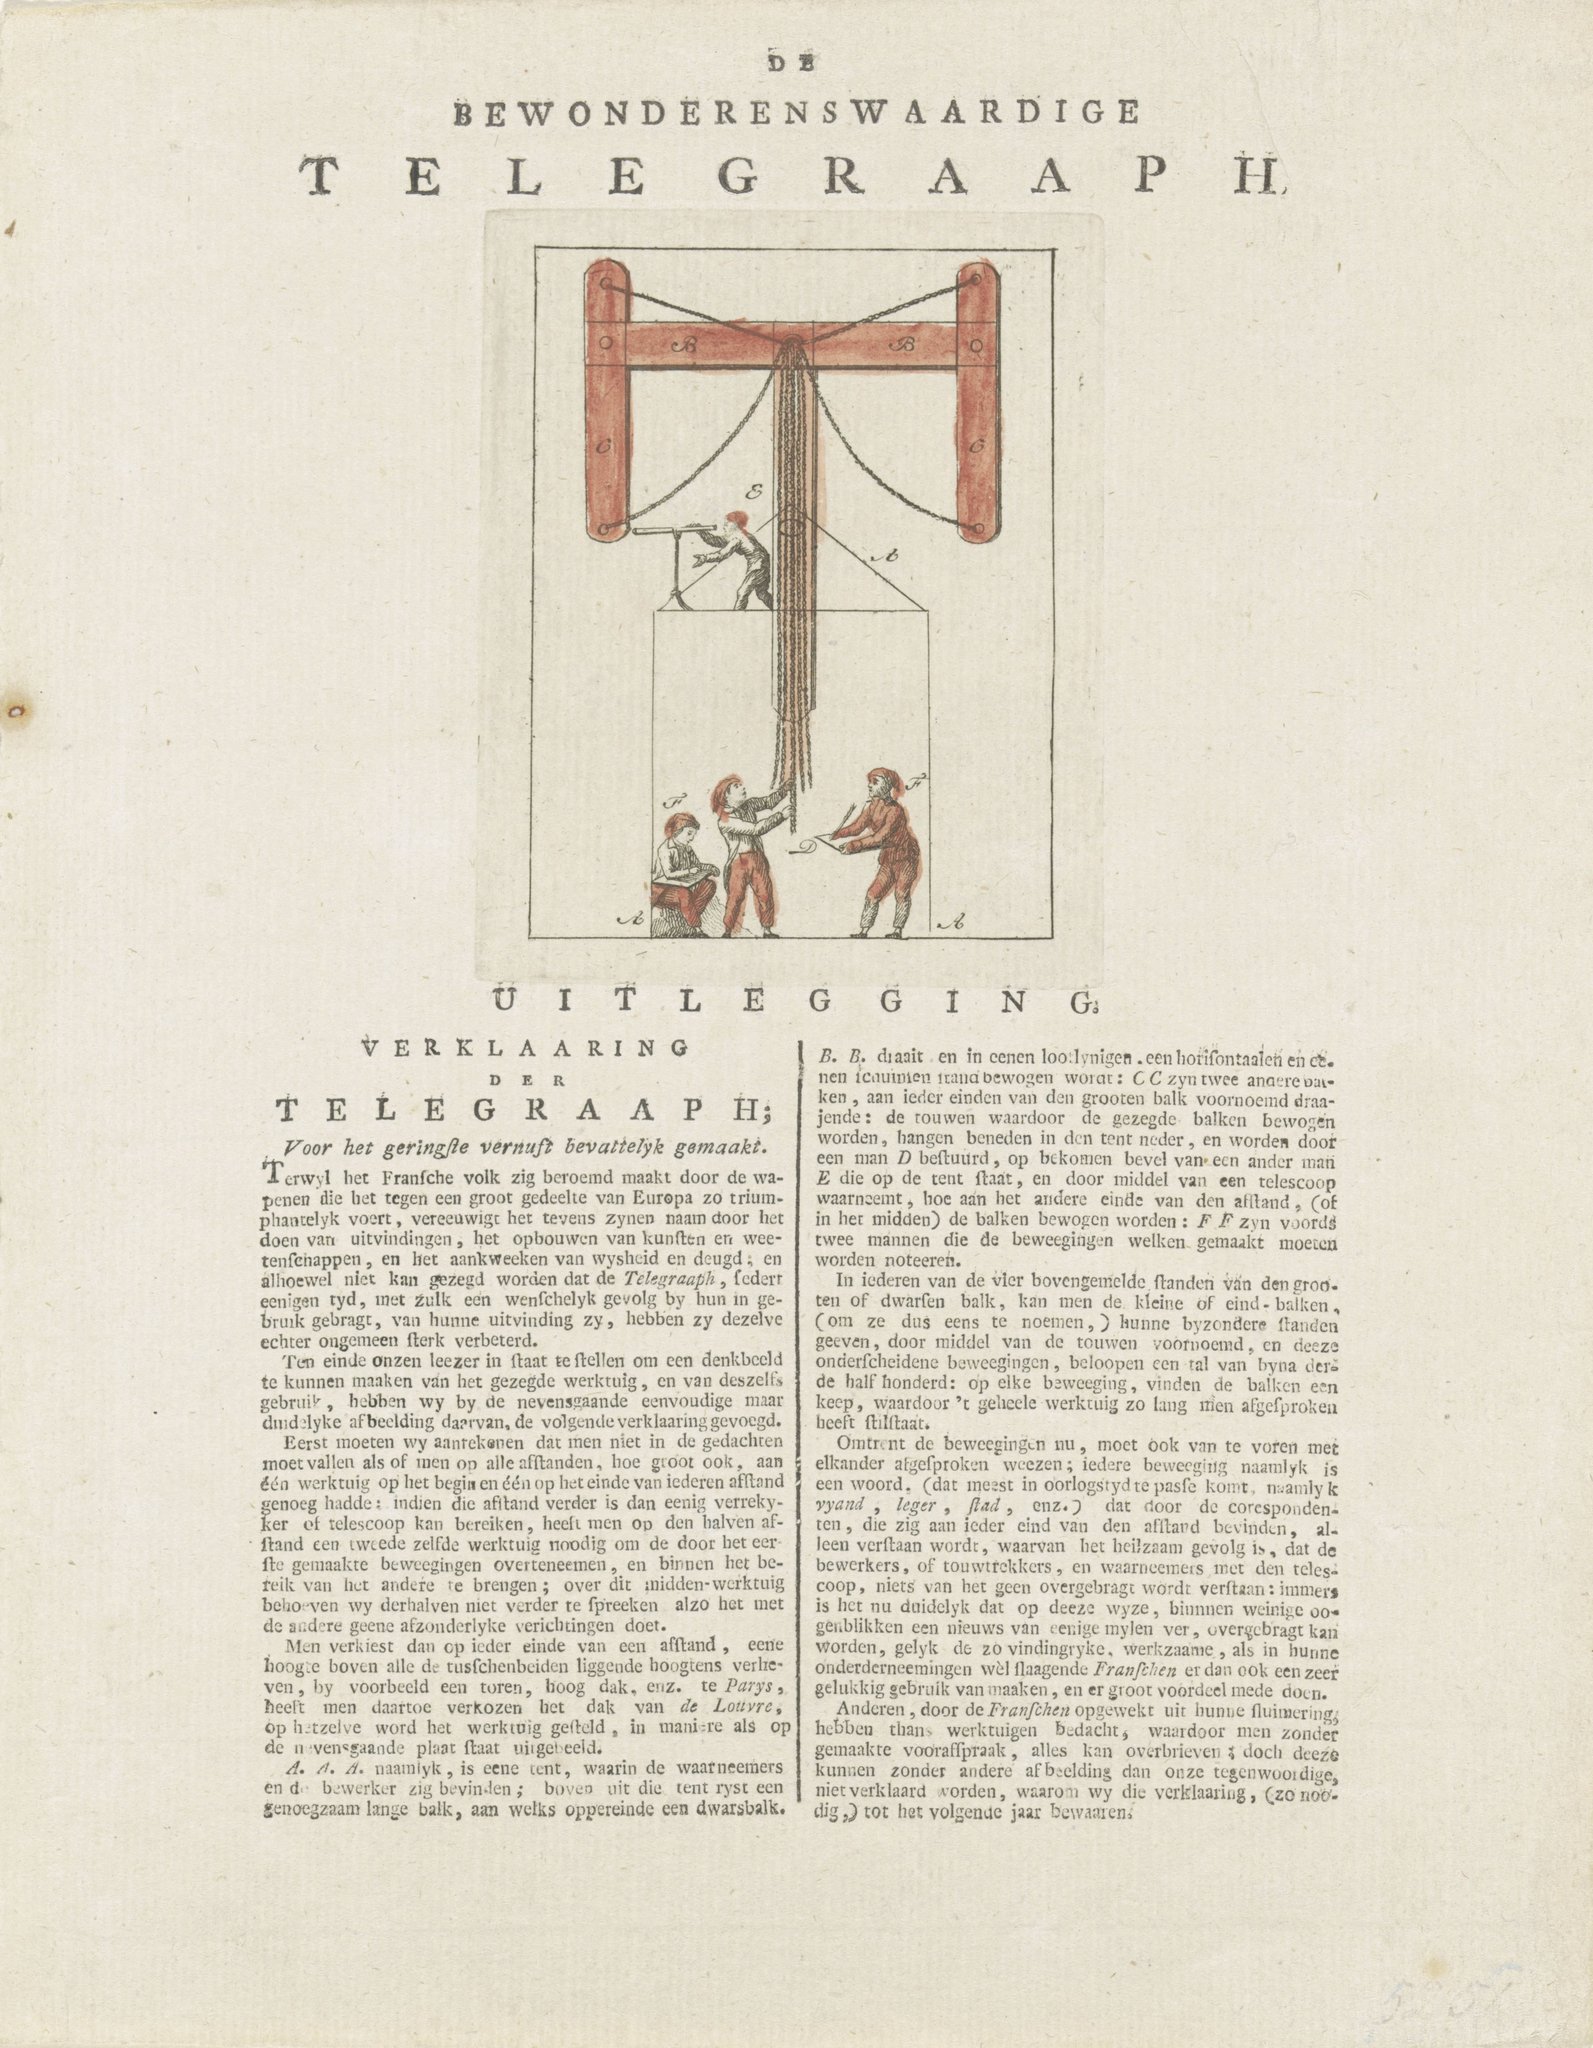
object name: print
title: De Bewonderenswaardige Telegraaph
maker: Anonymous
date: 1794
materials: paper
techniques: etching, hand coloring, letterpress printing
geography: northern netherlands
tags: semaphore, france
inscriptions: collector's mark: Lugt 2228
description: Blad over de werking van een nieuwe Franse semafoor of optische telegraaf, 1794. Bovenaan een voorstelling, daaronder de uitleg in twee kolommen.